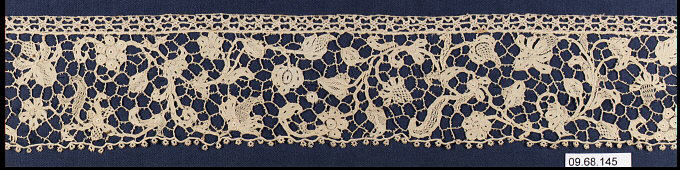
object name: border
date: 1601-1700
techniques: lace